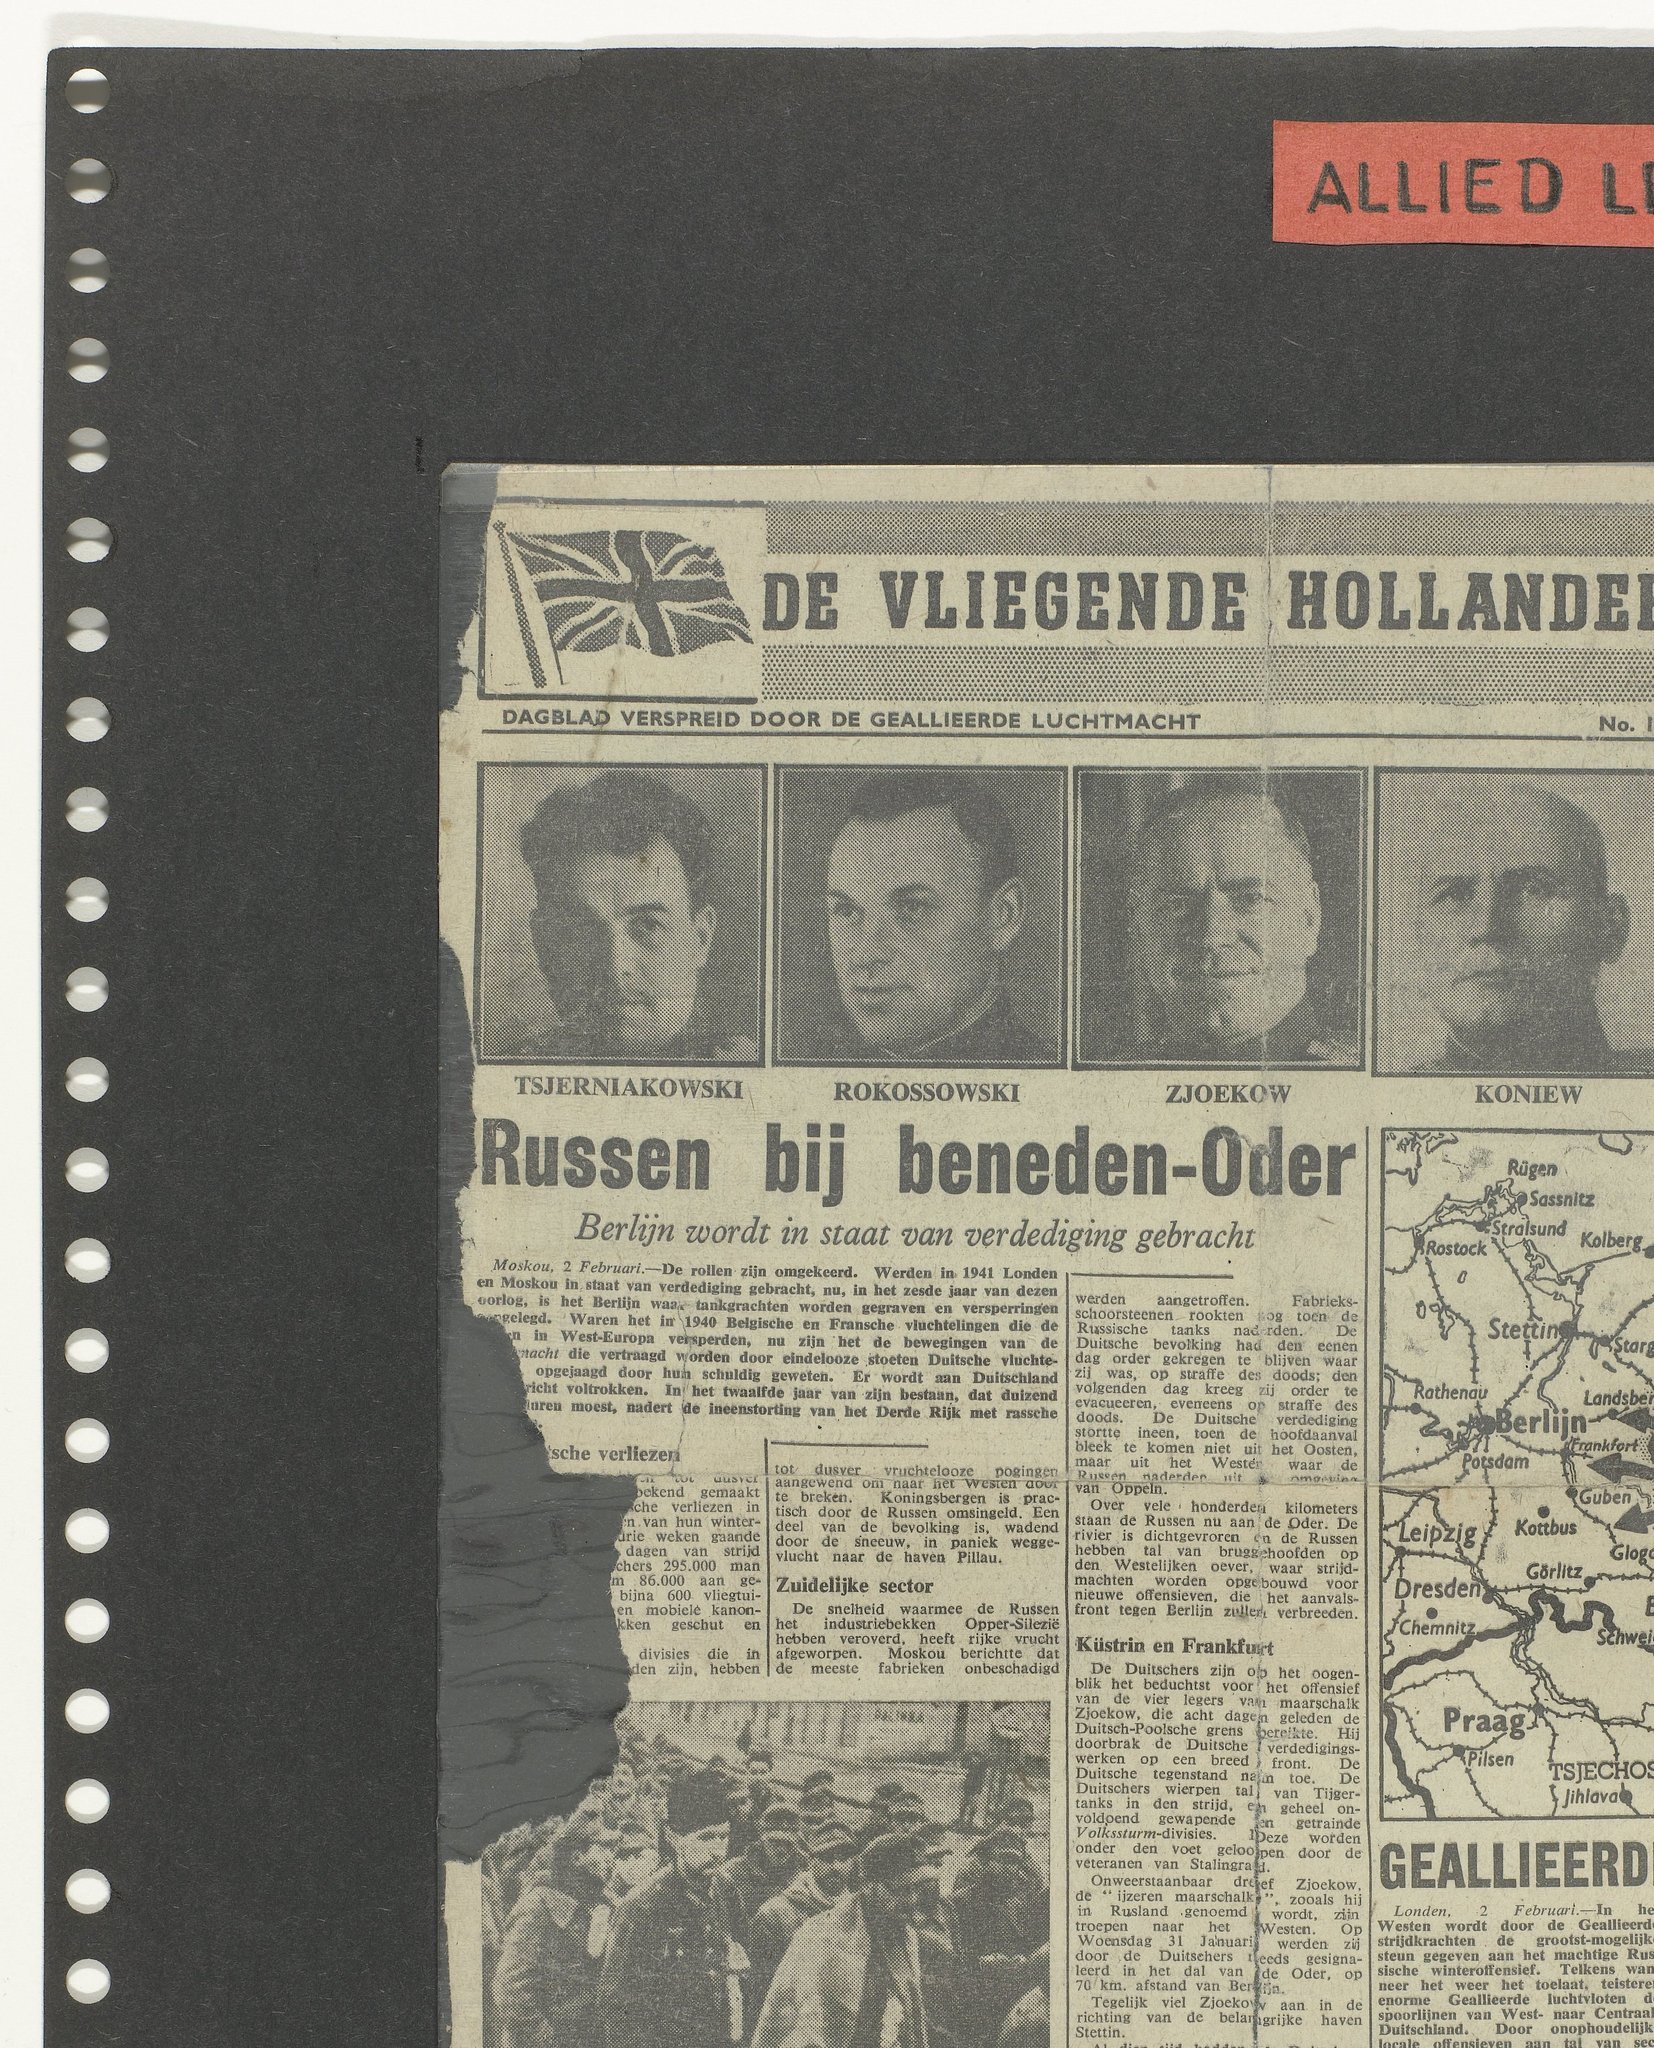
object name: album leaf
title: Foto en collageboek 'De Verborgen Camera'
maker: Anonymous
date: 1945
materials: paper, plastic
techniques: printing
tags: amsterdam, tonny van renterghem, berlin, fritz kahlenberg, underground movement, partisans, newspaper, news-sheet, netherlands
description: Nummer van De Vliegende Hollander, nr. 100, 2 februari 1945, een dagblad dat werd verspreid door de geallieerde luchtmacht.